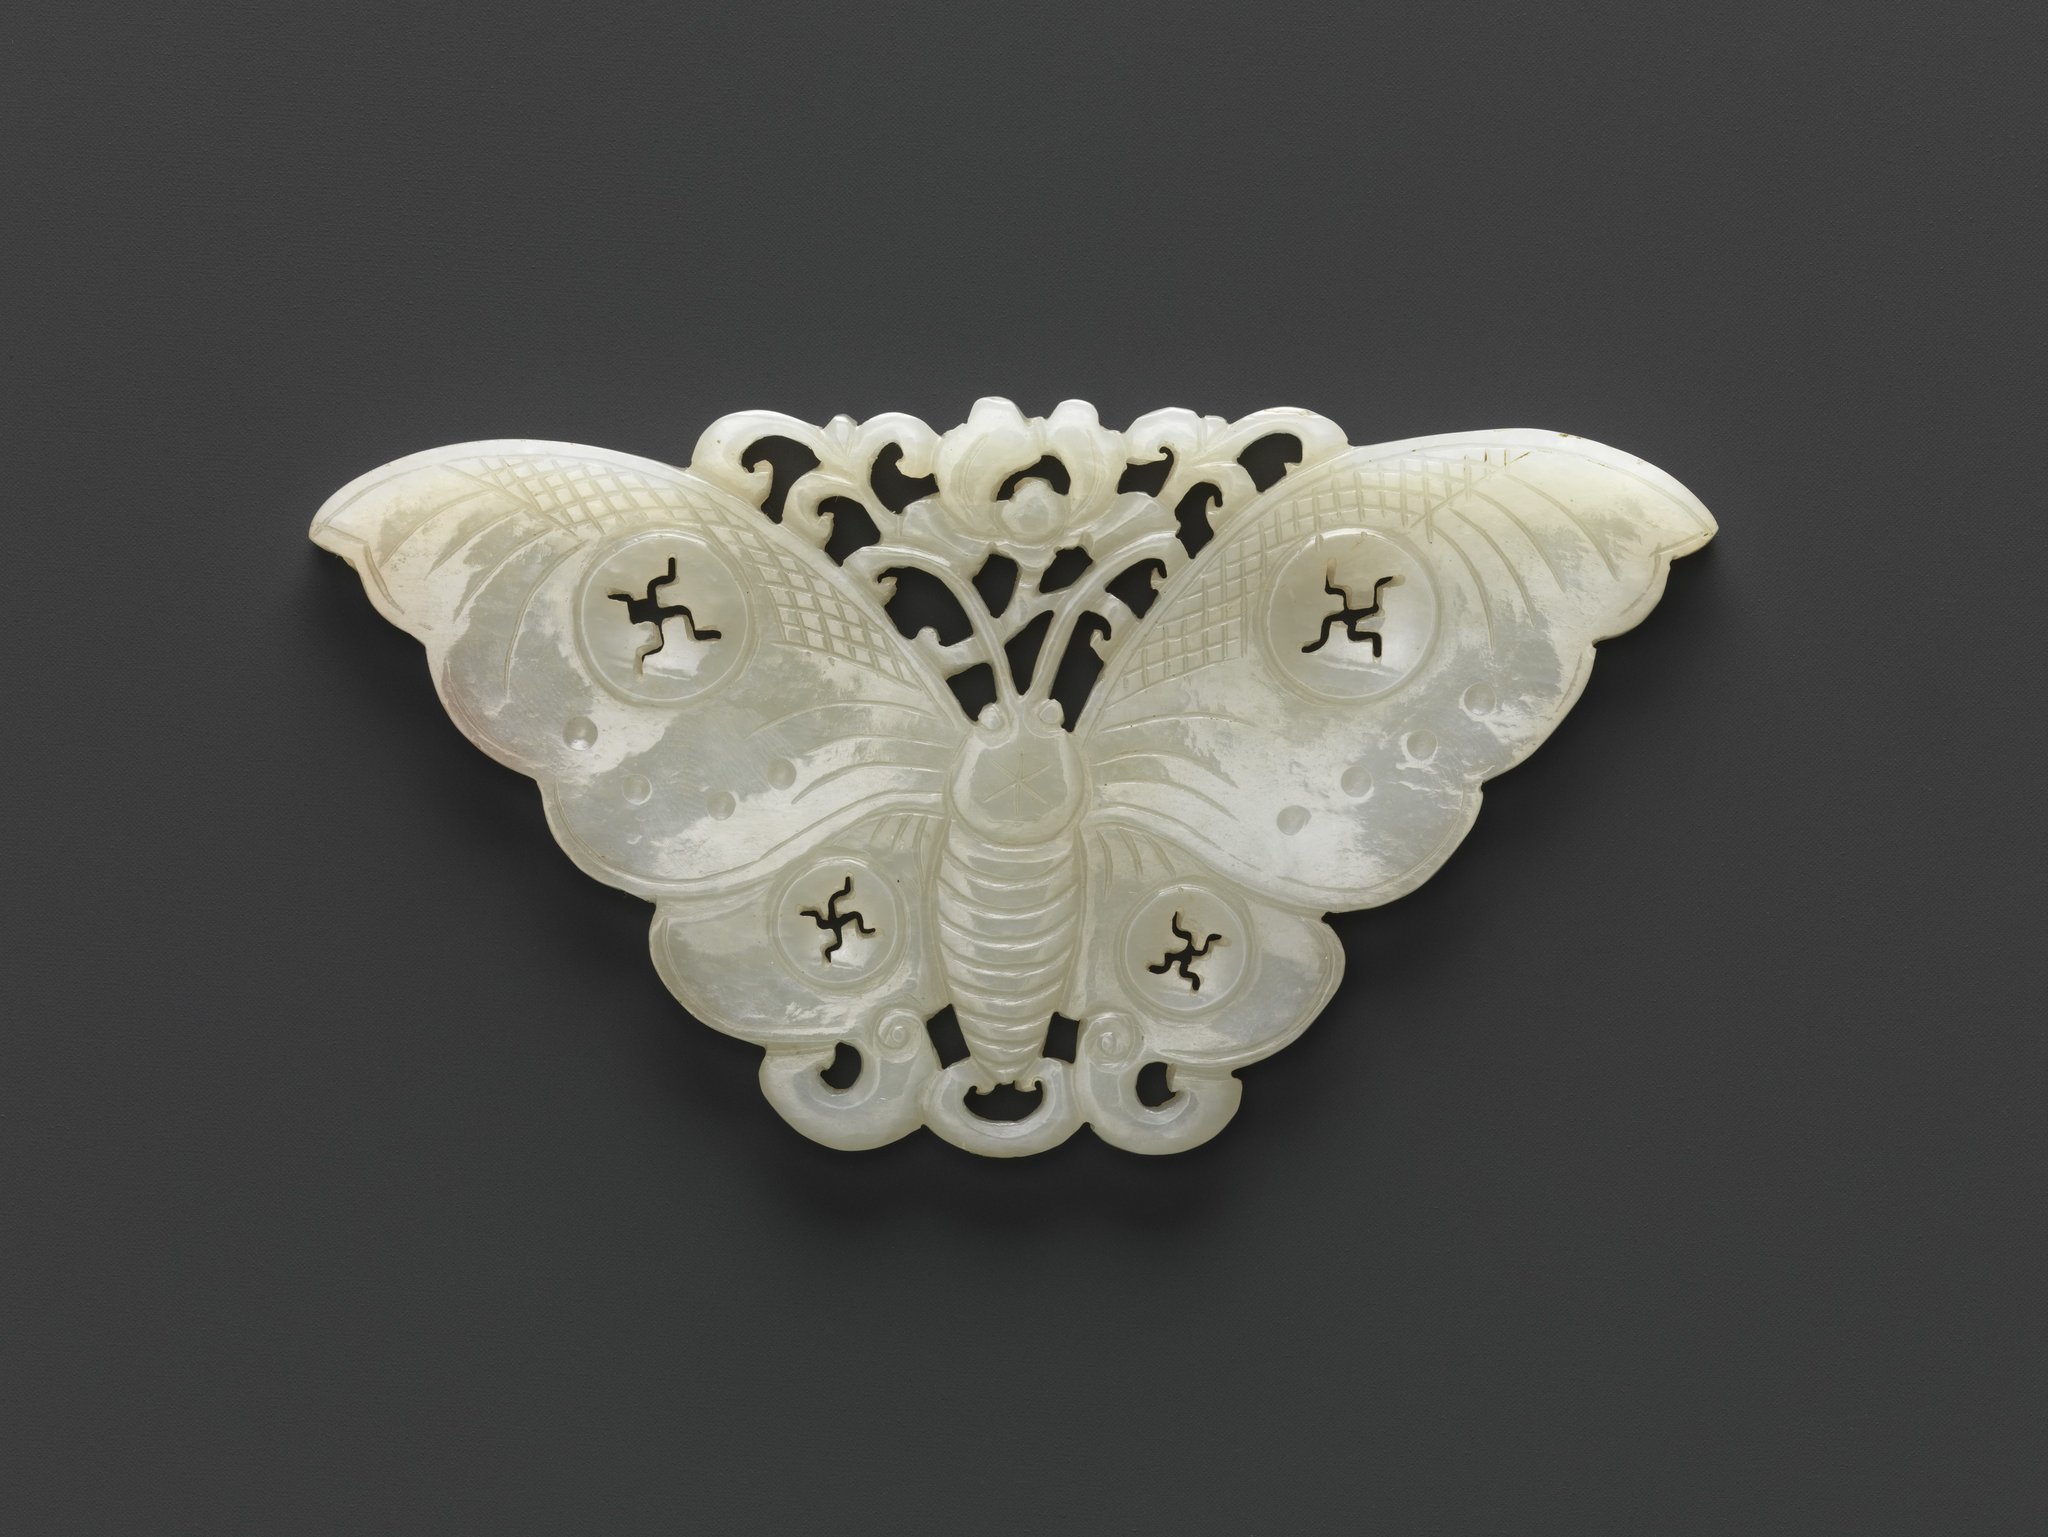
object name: figure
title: Butterfly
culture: chinese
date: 1701-1800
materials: jade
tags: butterflies